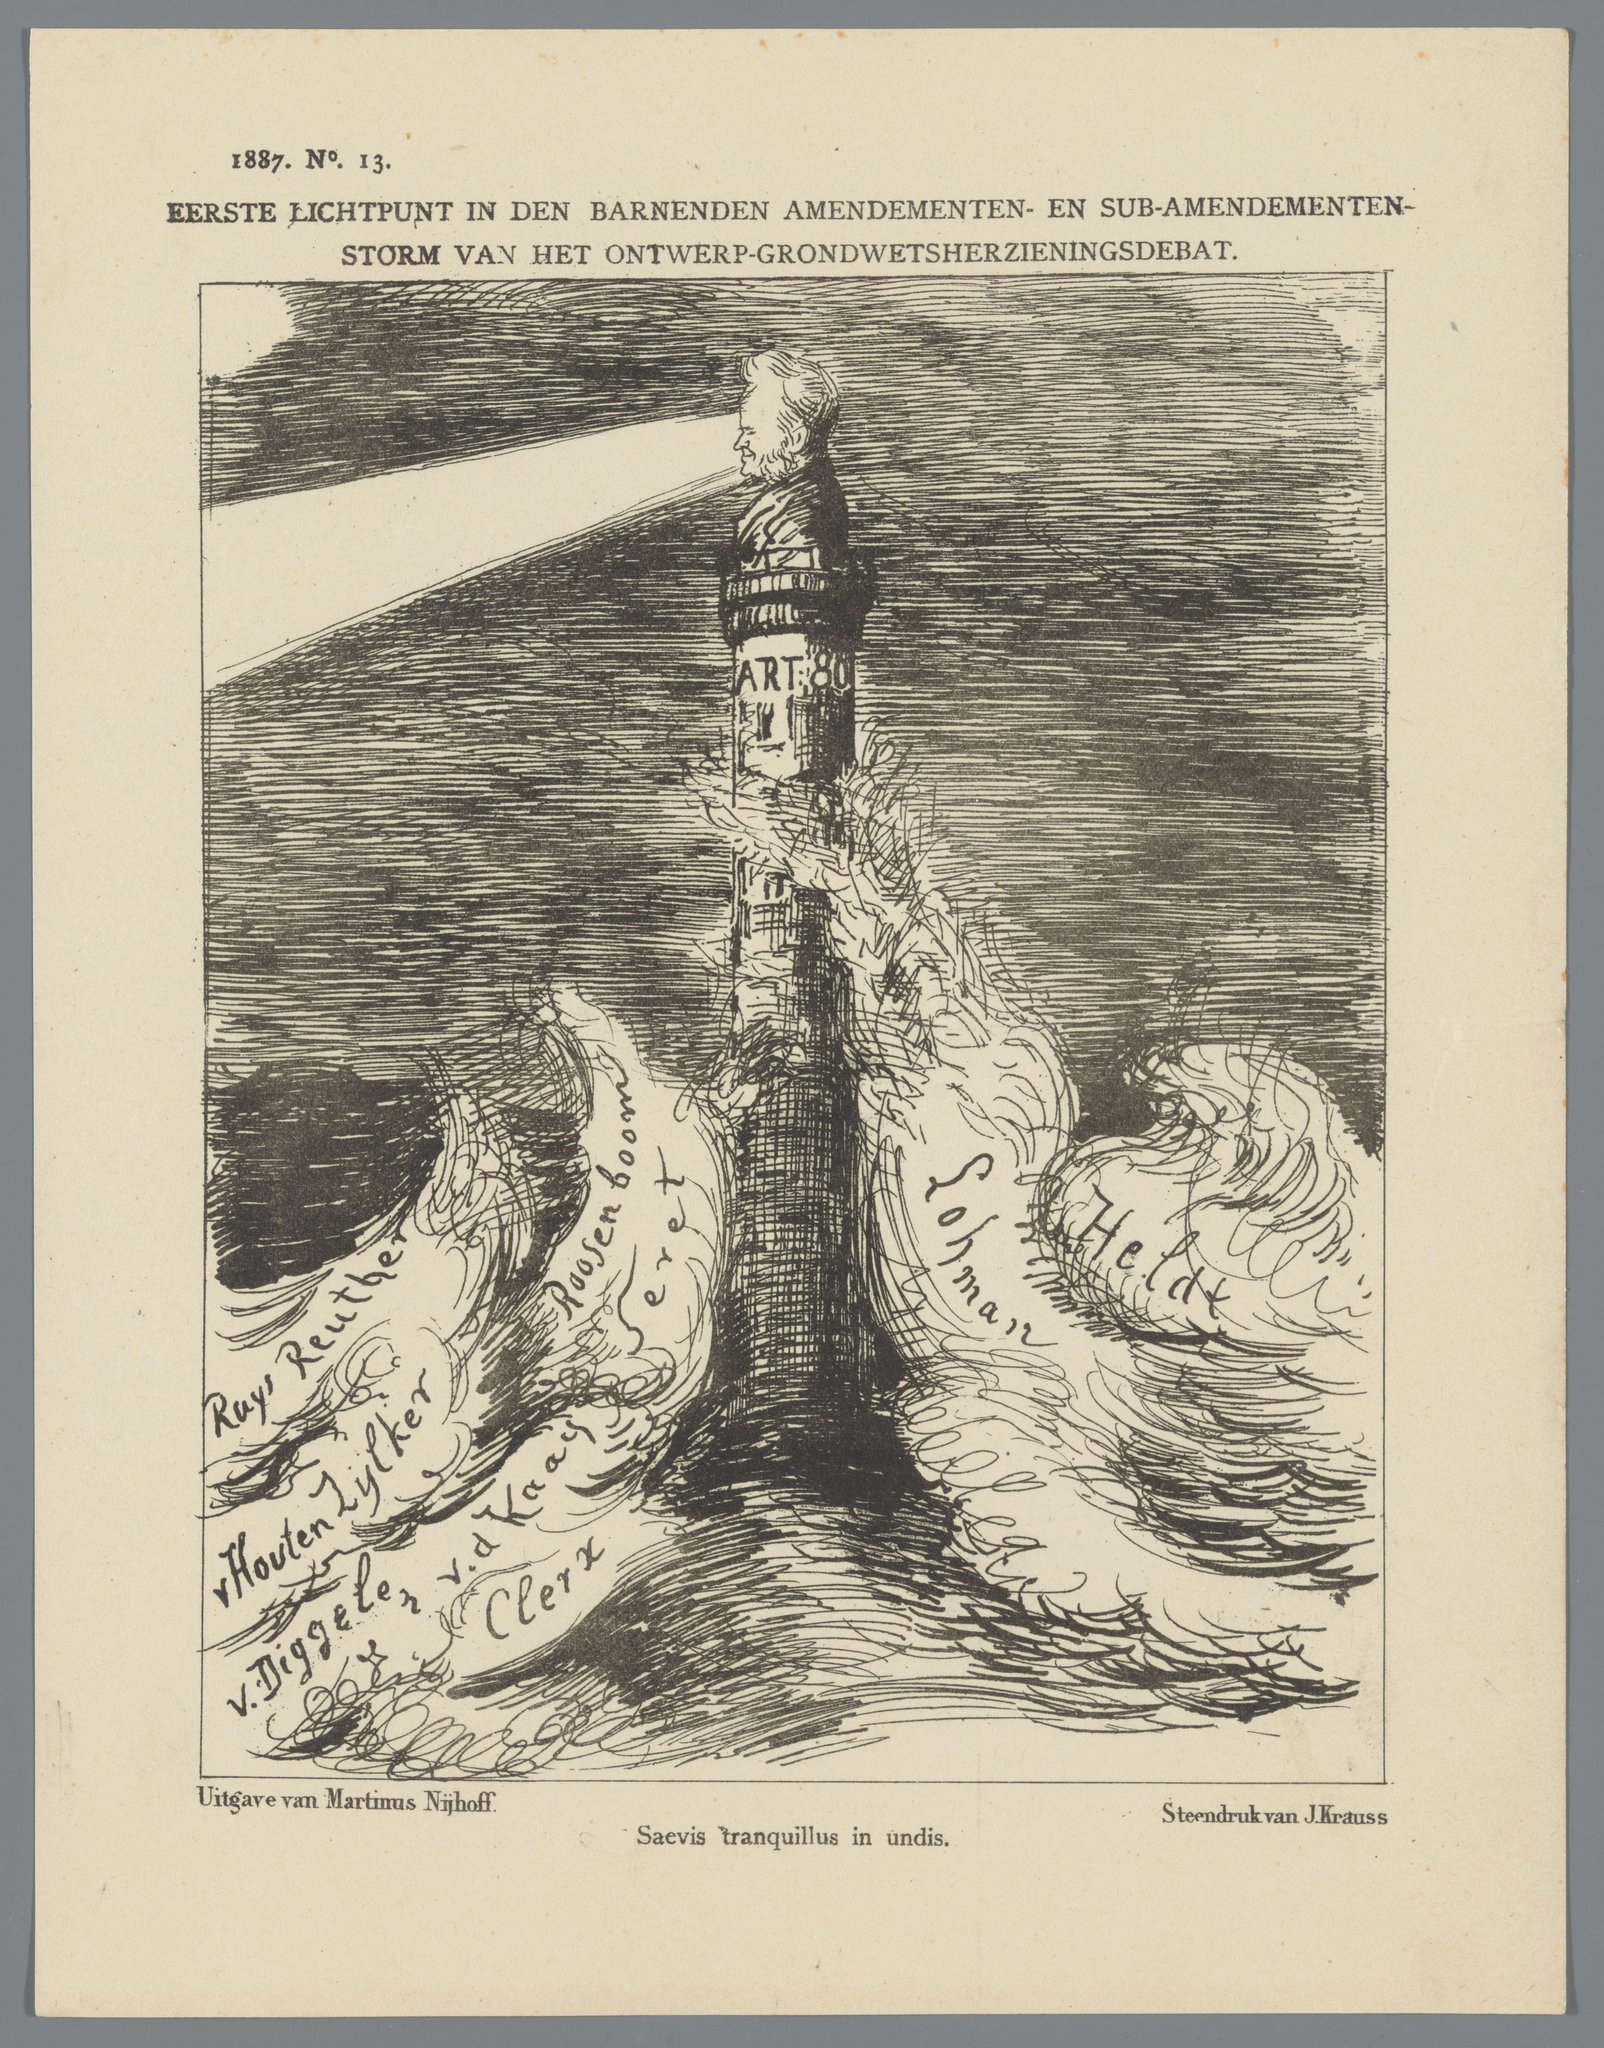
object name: cartoon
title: Spotprent over het grondwetsherzieningsdebat, 1887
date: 1887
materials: paper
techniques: lithograph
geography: the hague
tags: amsterdam, politician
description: Spotprent over het grondwetsherzieningsdebat, 1887. Minister Heemskerk als baken in de storm. Plaat verschenen bij het weekblad De Nederlandsche Spectator, nr. 13, 1887.